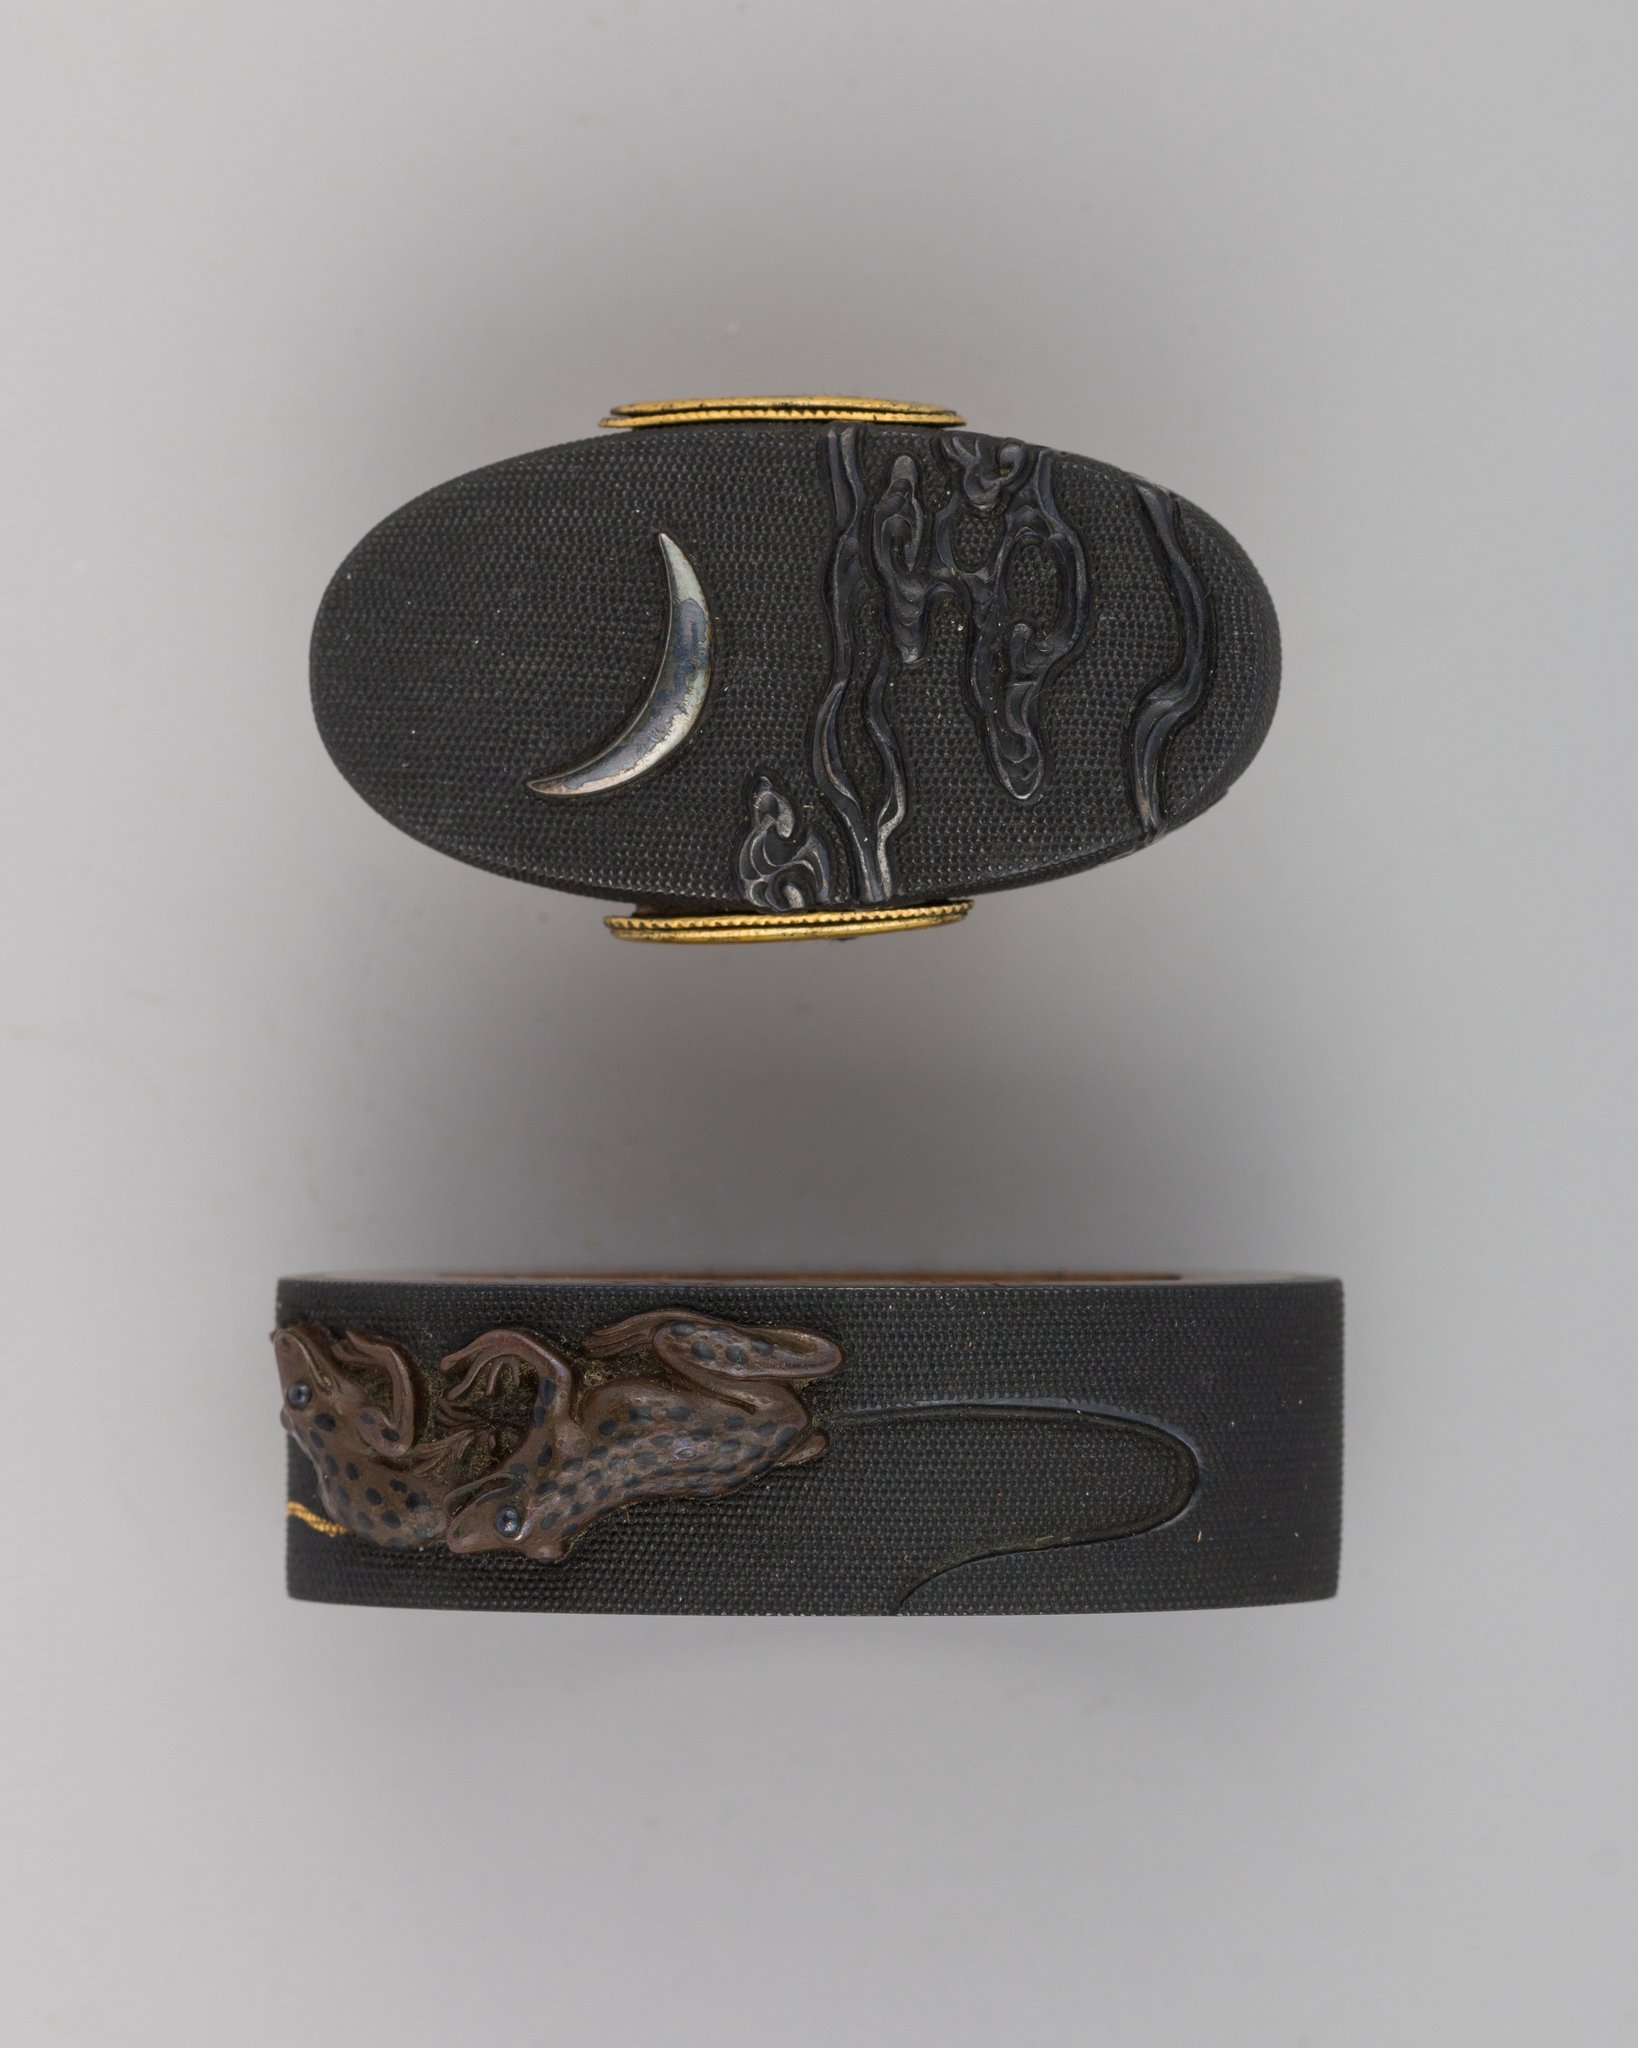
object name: sword hilt collar and pommel fuchigashira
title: Sword-Hilt Collar and Pommel (Fuchigashira)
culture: japanese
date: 1801-1900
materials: gold alloy, gold, silver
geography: japan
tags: moon